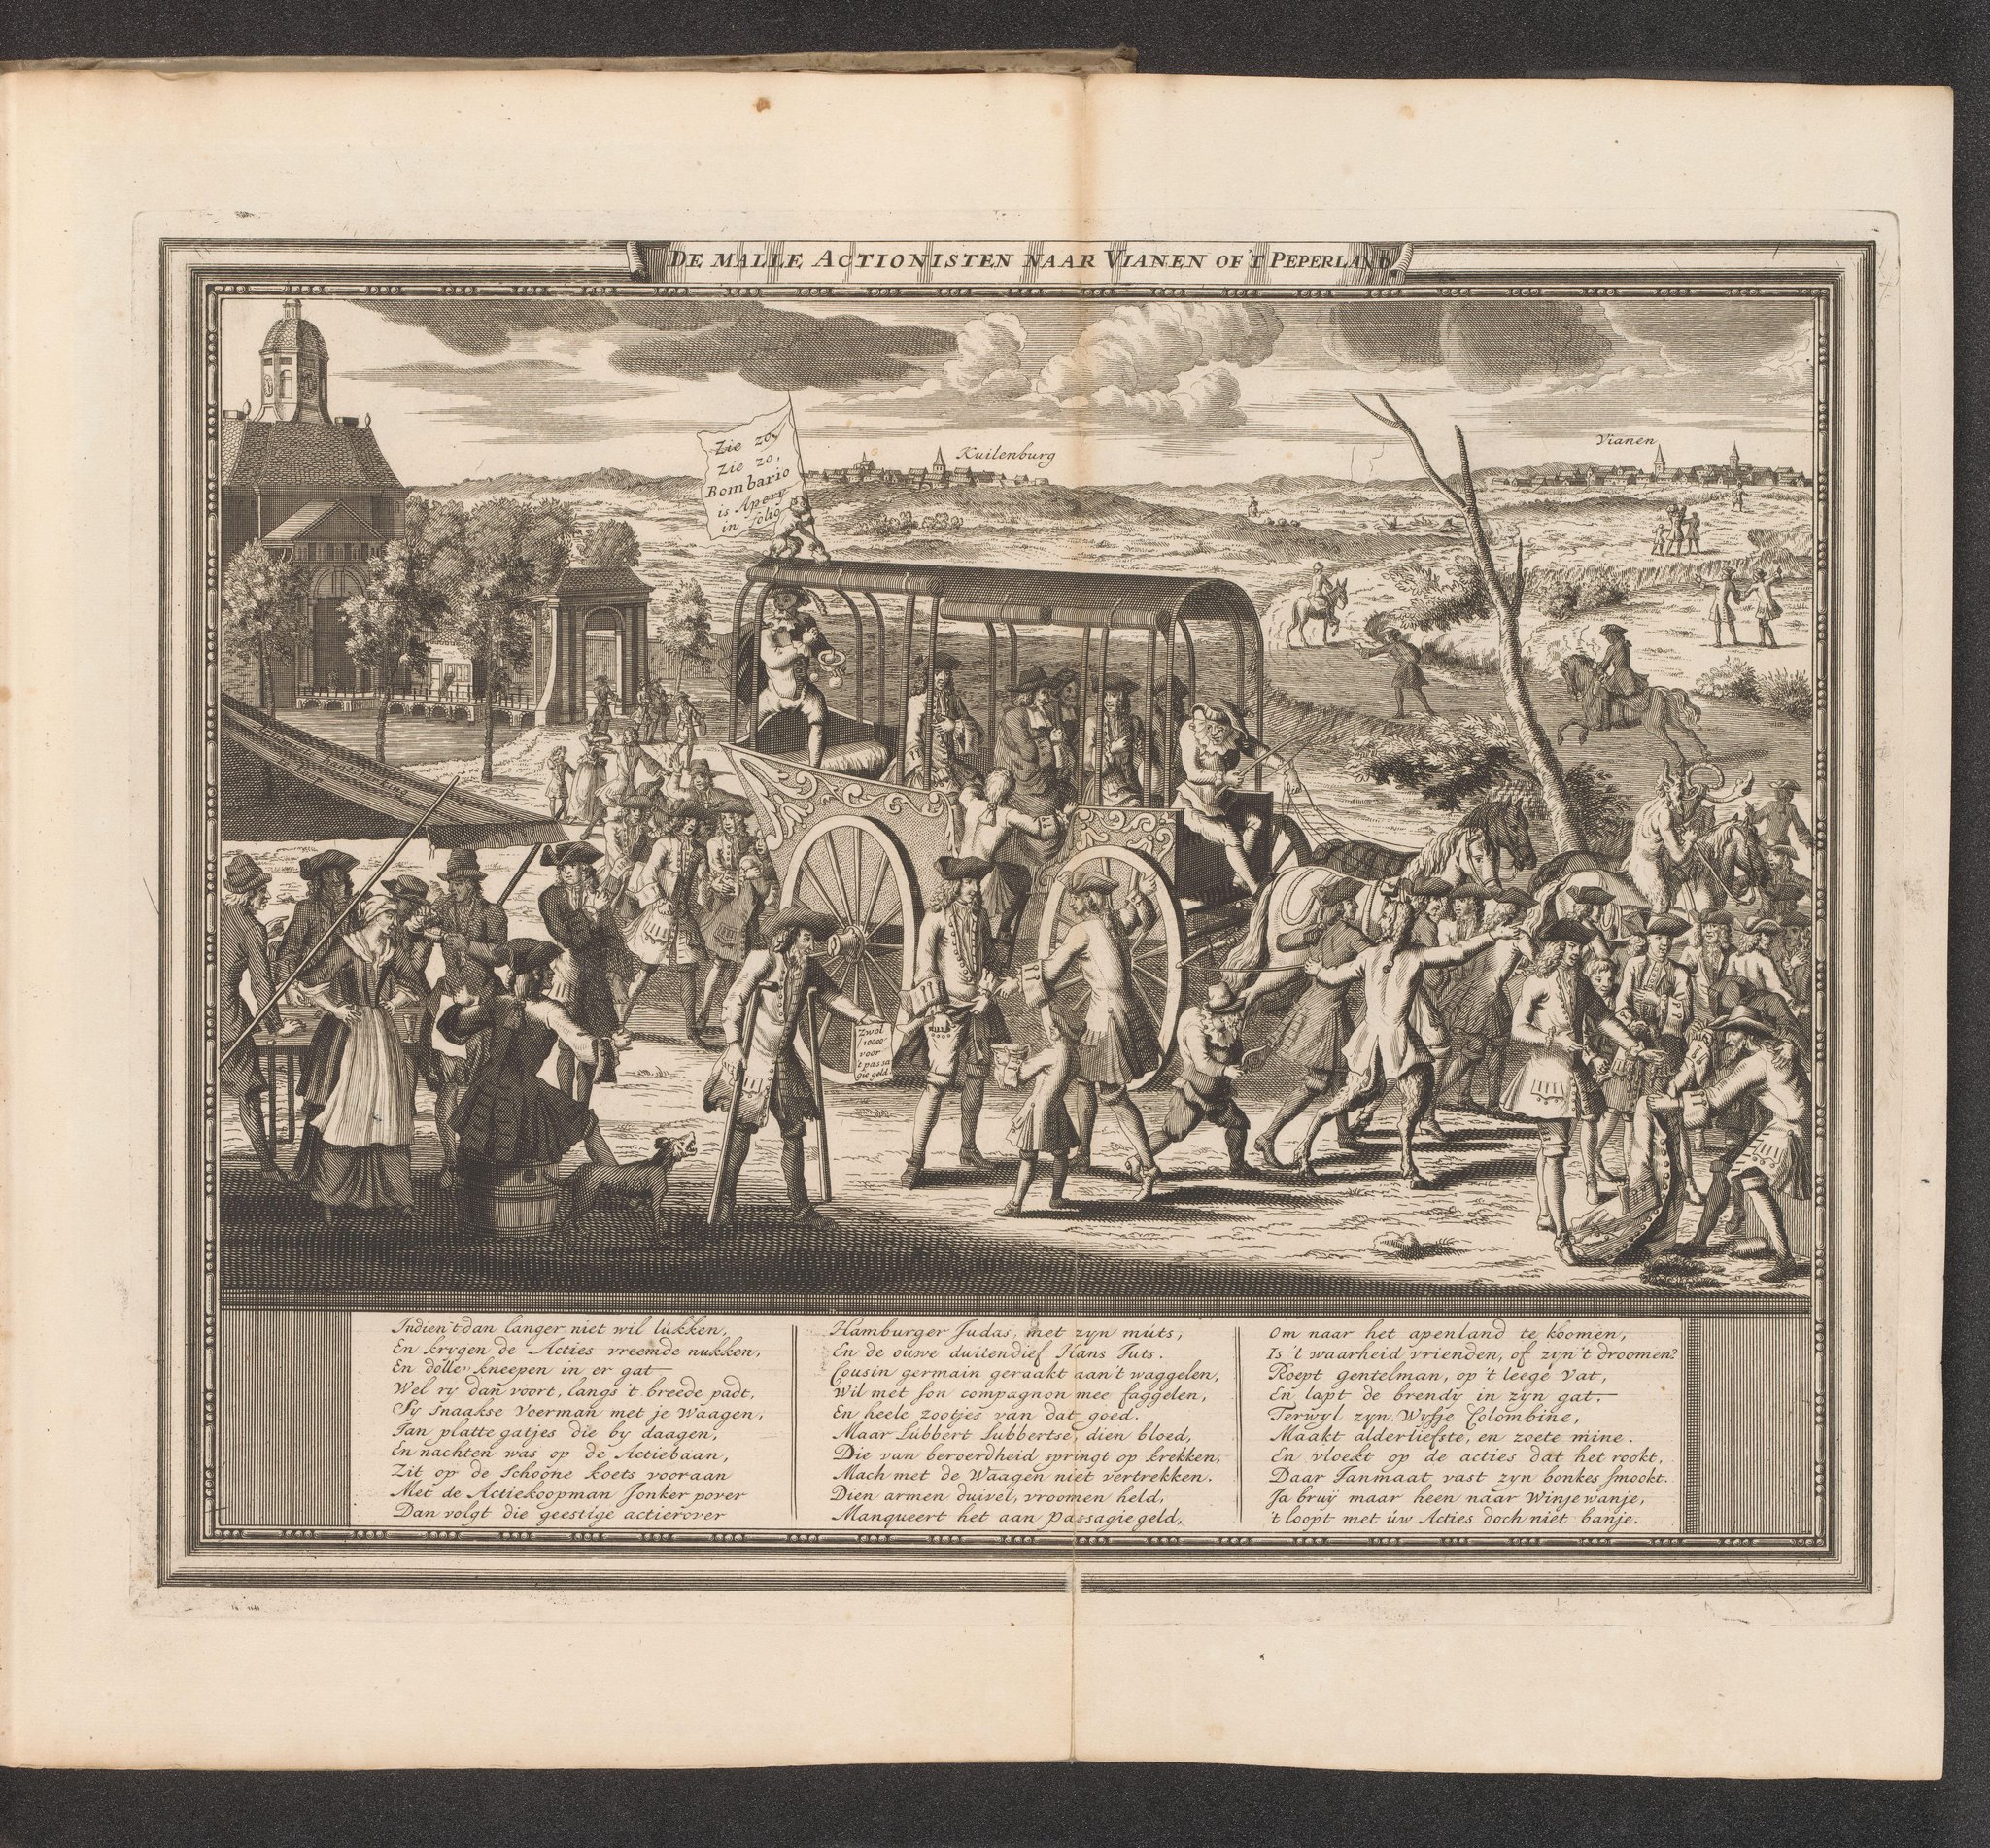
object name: print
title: De Malle Actionisten naar Vianen of 't Peperland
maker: Anonymous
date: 1720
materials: paper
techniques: etching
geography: northern netherlands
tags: four-wheeled vehicle drawn by three animals, financial panic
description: Een wagen met Actionisten verlaat Amsterdam bij de Muiderpoort en rijdt richting Vianen en Culemborg. De reiswagen wordt gemend door een nar, op het dak rijdt een aap met een vaandel met Bombario, de paarden worden geleid door een duivel. In en om de wagen actionisten of windhandelaren. In het onderschrift een tekst in drie verzen. Prent in de gebonden eerste uitgave (304 B 10) van Het Groote Tafereel der Dwaasheid met spotprenten op de Windhandel of Actiehandel van 1720.